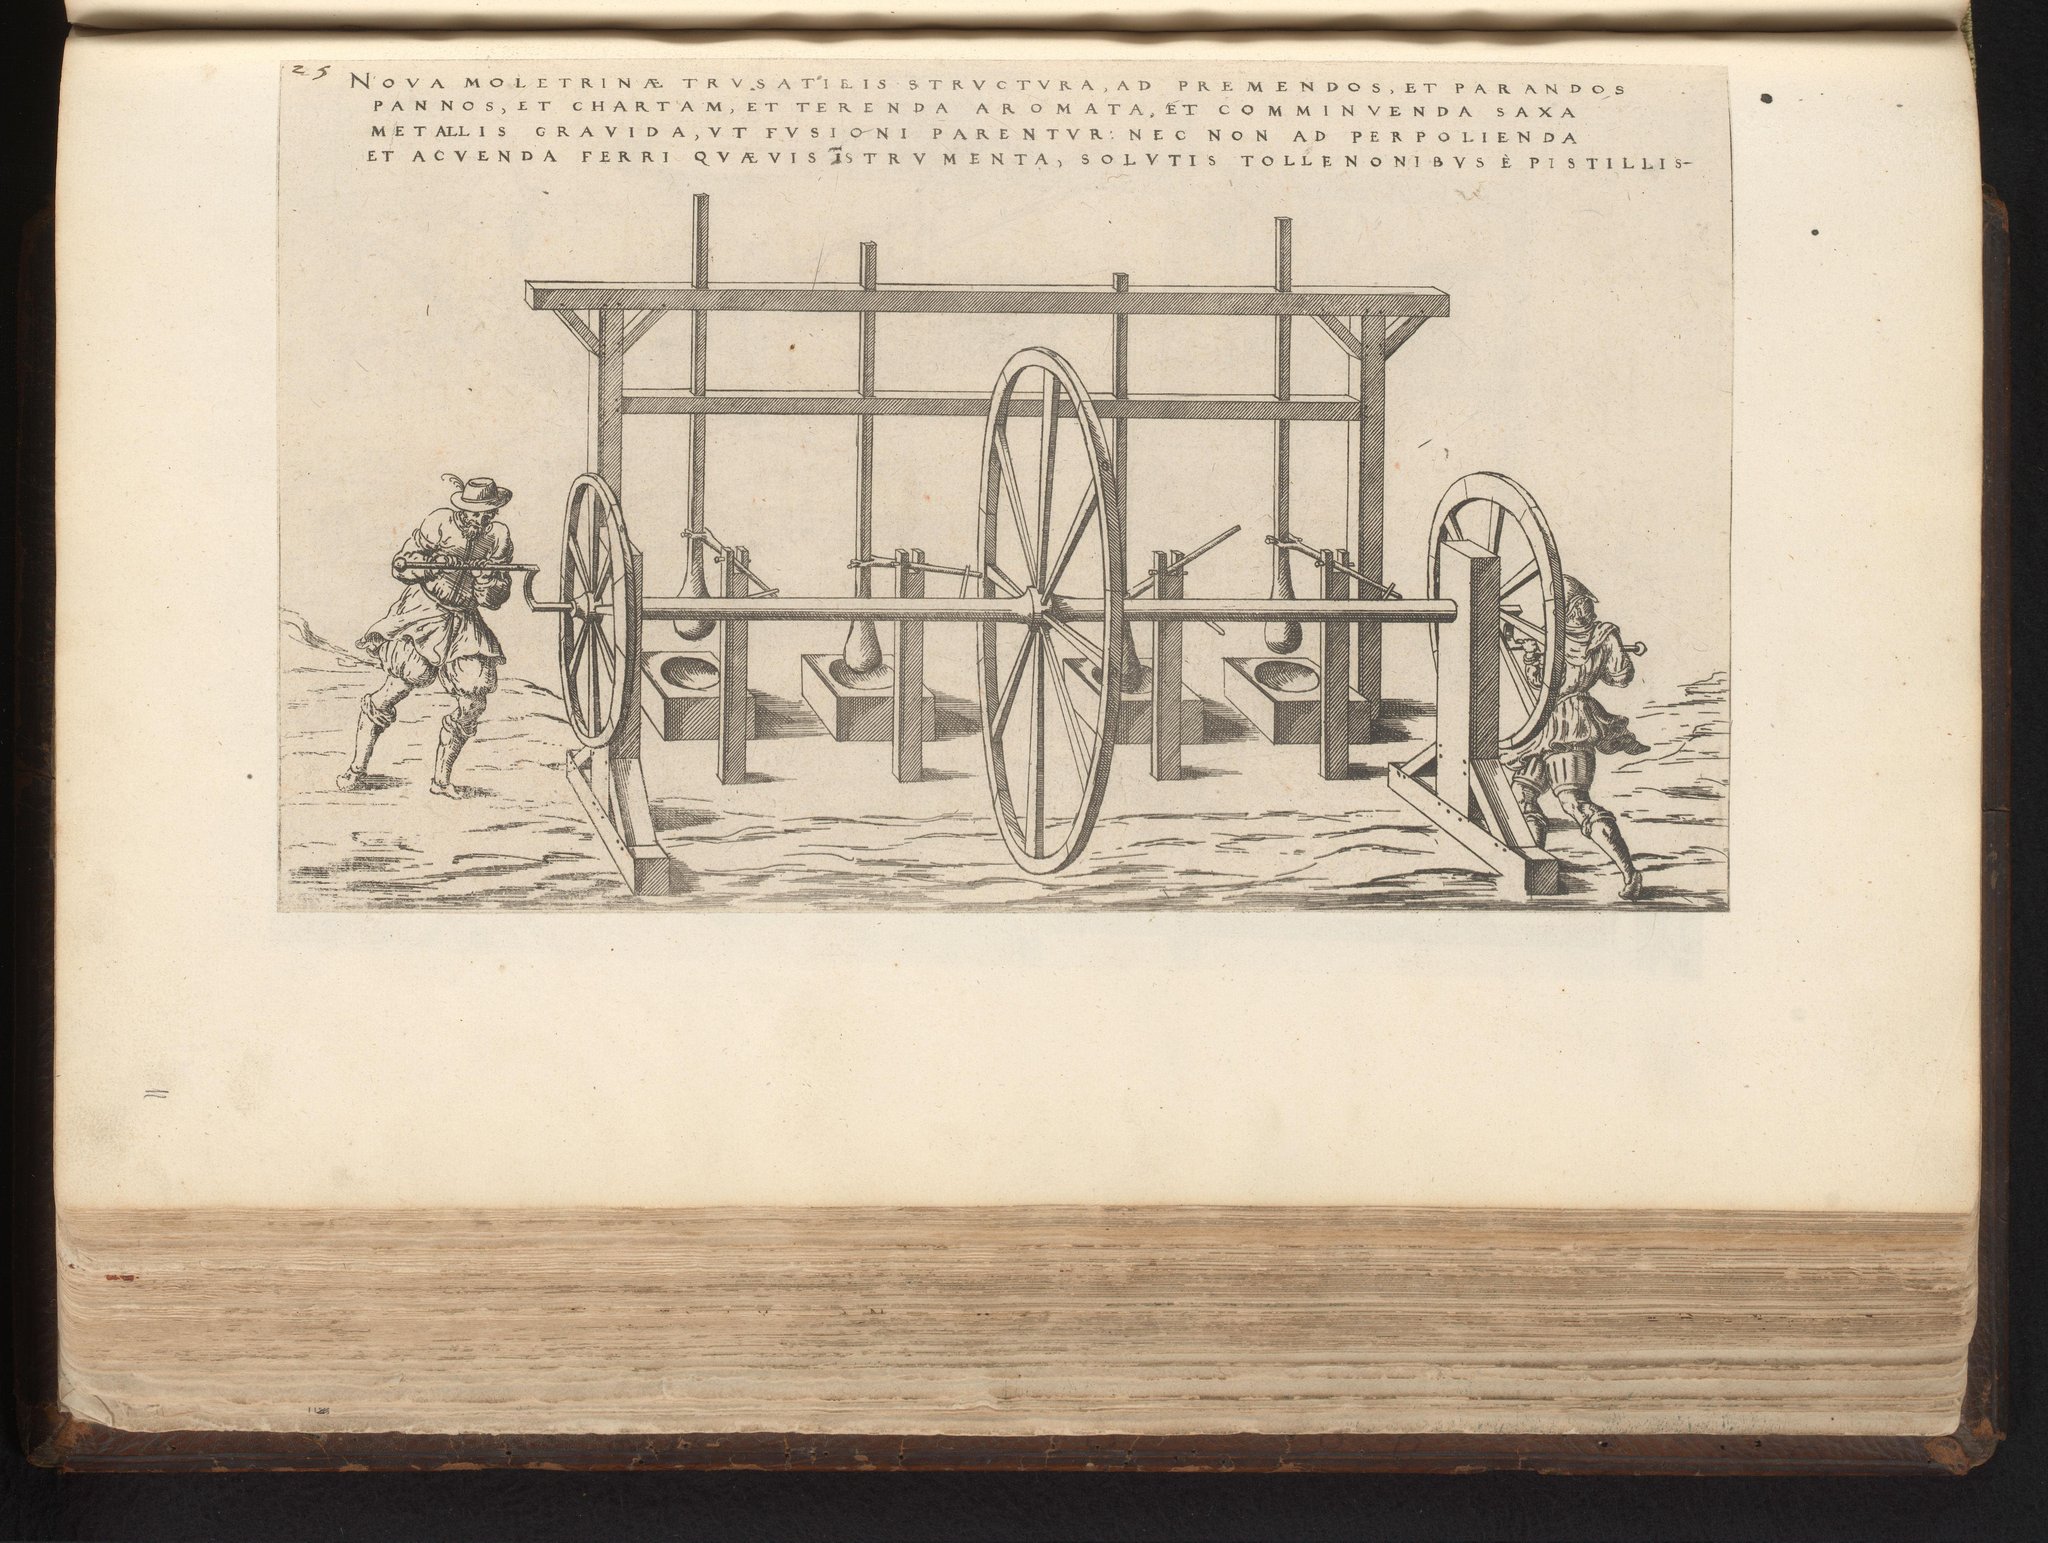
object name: album leaf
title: Molen met vier vijzels, aangedreven door twee werkers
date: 1579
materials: paper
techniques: etching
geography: lyon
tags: grinding, milling (industrial processes), pestle and mortar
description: Prent uit: Besson, Jacques. Theatre des instrumens mathematiques & mechaniques. Lyon: Barthelemy Vincent, 1579. Prent voor het eerst verschenen in de eerste editie van ca. 1569.